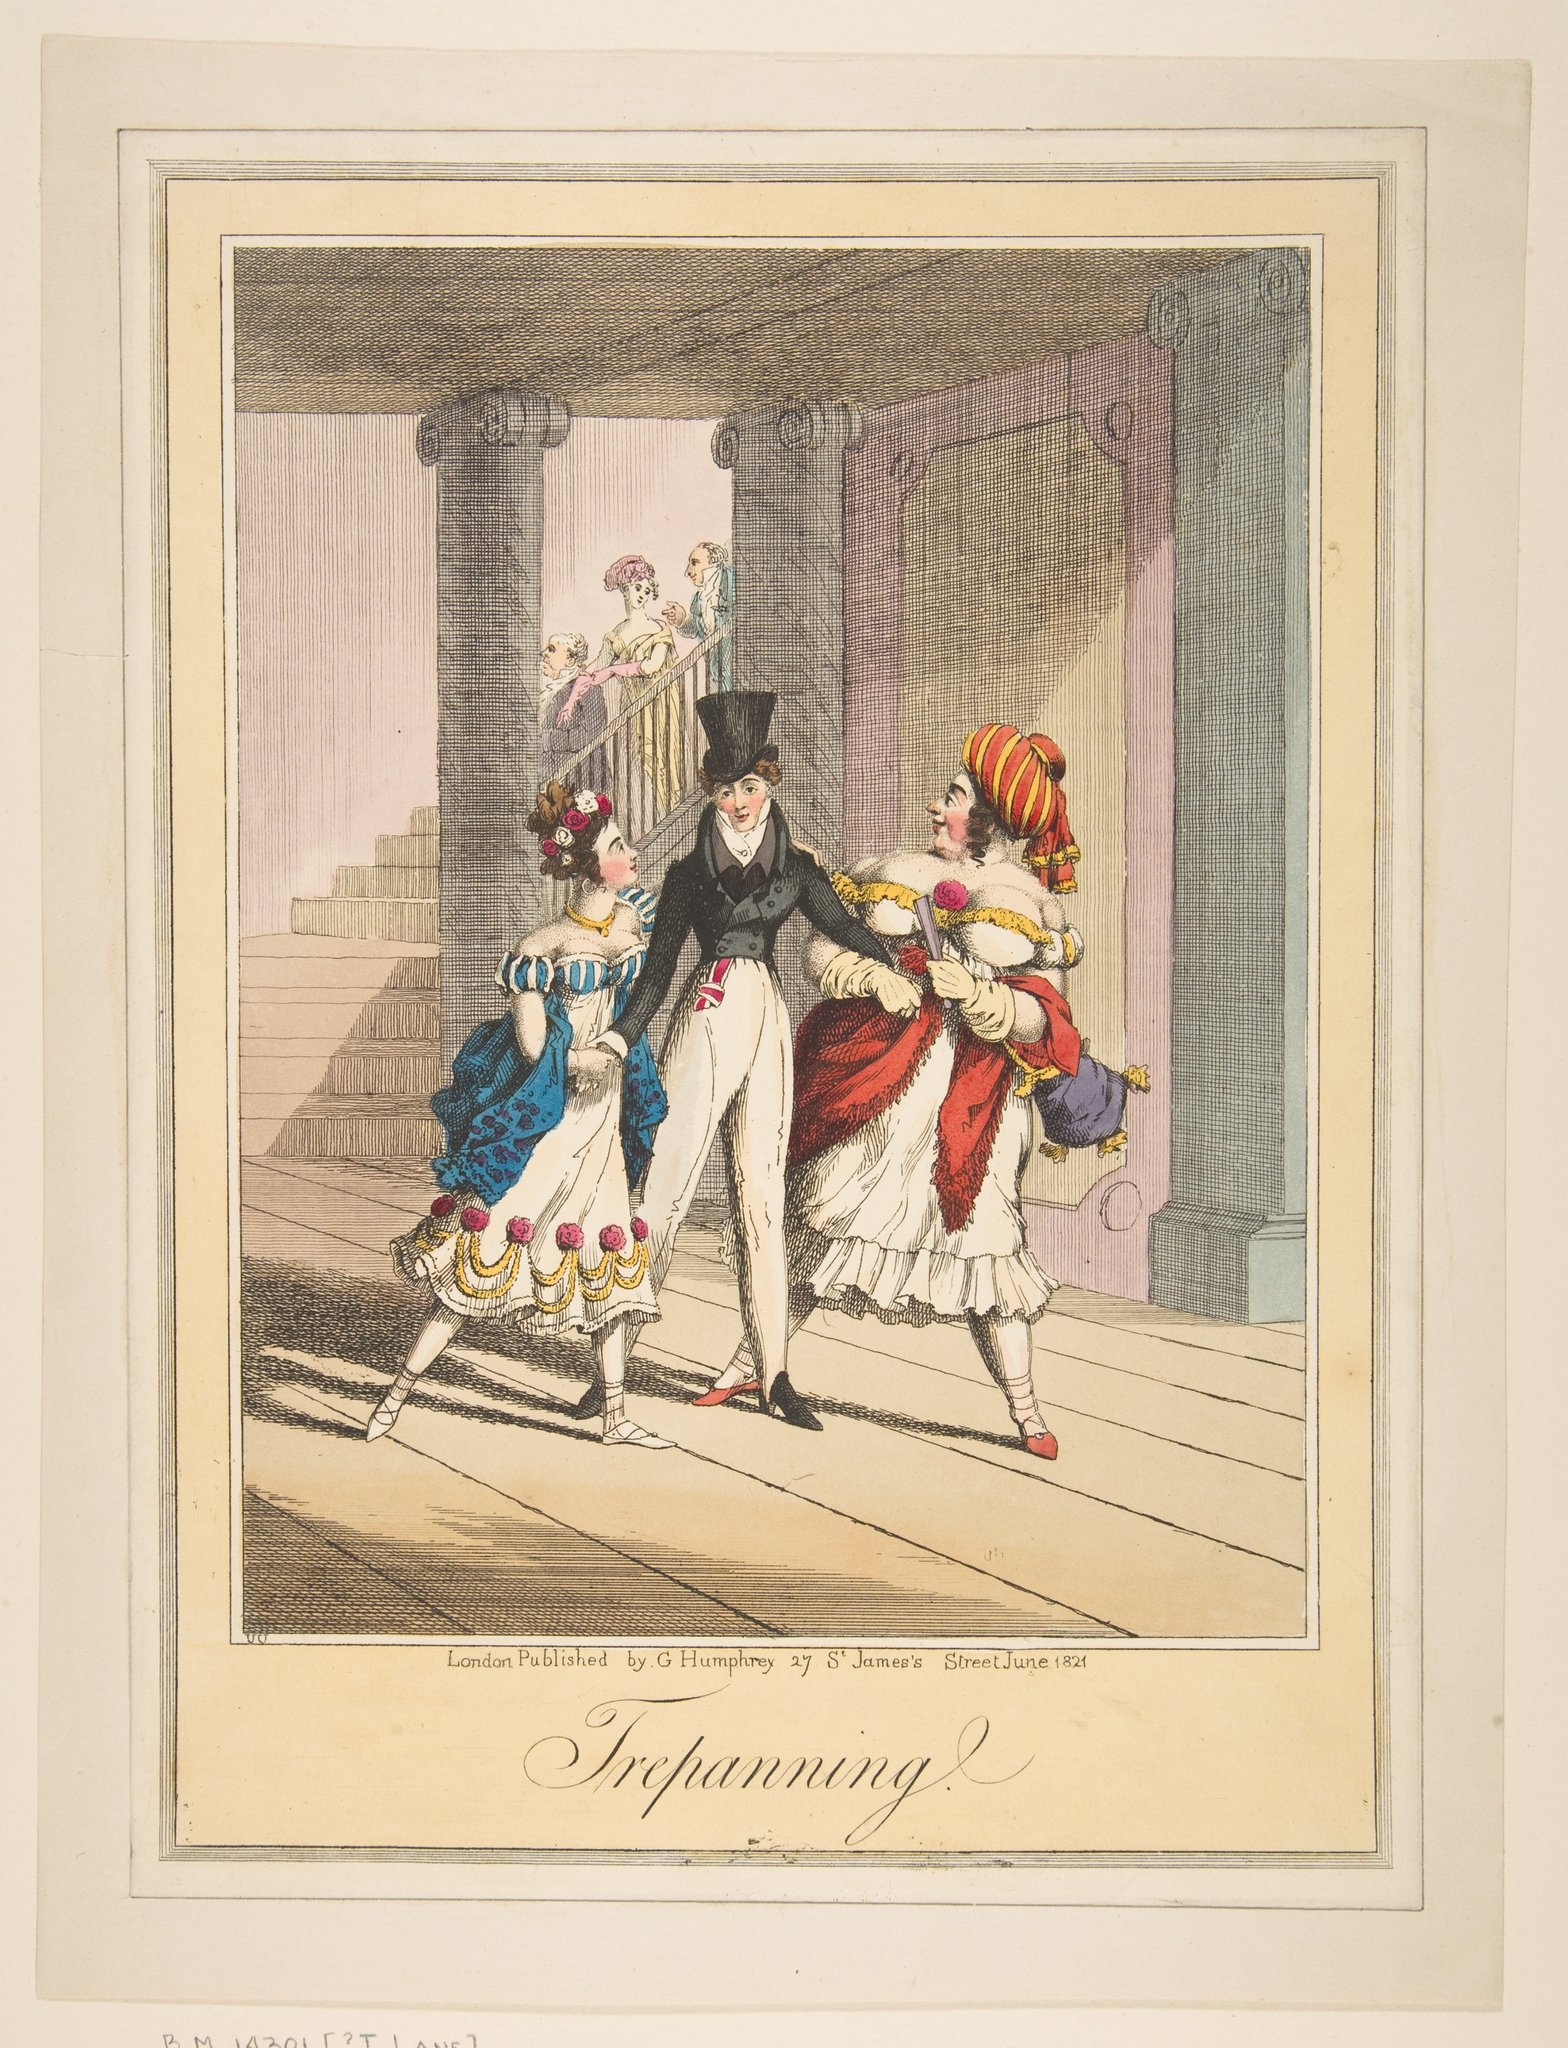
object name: print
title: Trepanning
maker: theodore lane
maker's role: artist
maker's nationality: british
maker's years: 1800-1828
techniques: etching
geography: london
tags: men,women